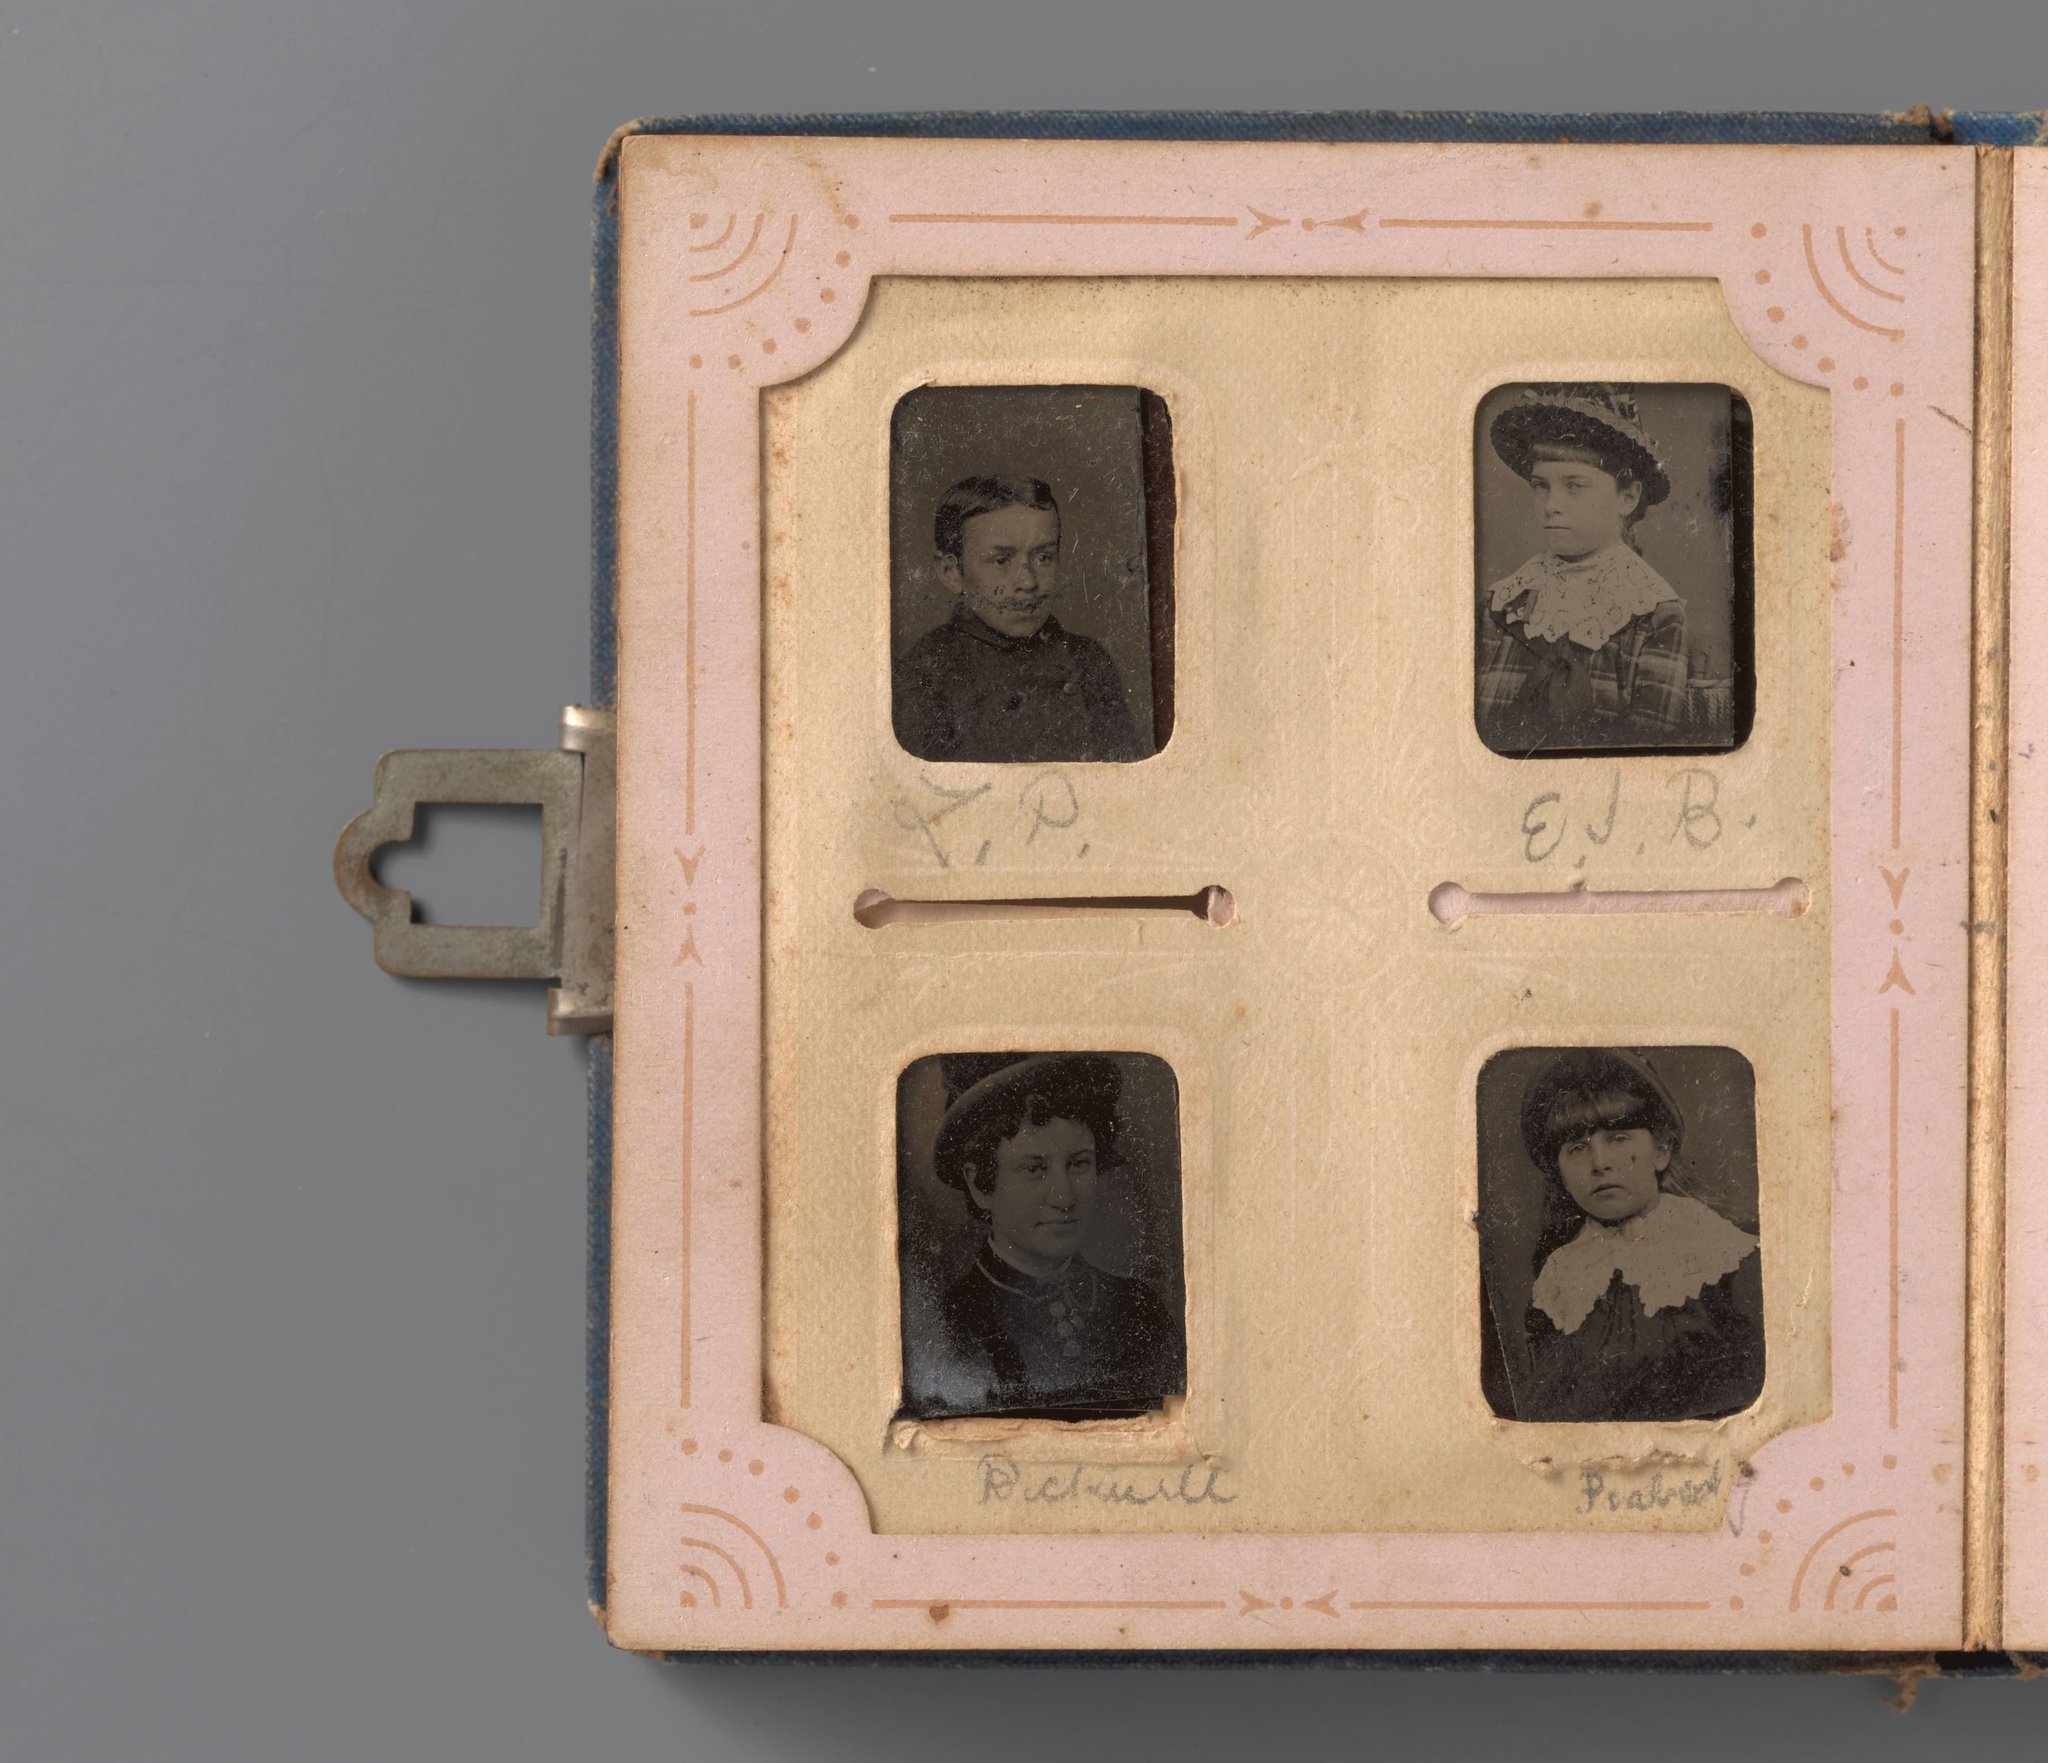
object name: album leaf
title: Vier portretten van jonge mannen en jonge vrouwen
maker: Anonymous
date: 1855-1940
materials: cardboard, iron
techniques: ferrotyping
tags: adolescent, young woman, maiden, historical persons - bb - woman, historical persons, youth, adolescent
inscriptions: monogram: ‘Z.P.’, name: ‘Prab[...]’, monogram: ‘E. J. B.’, name: ‘Rick[..]ll’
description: Deze foto's maken deel uit van een album.